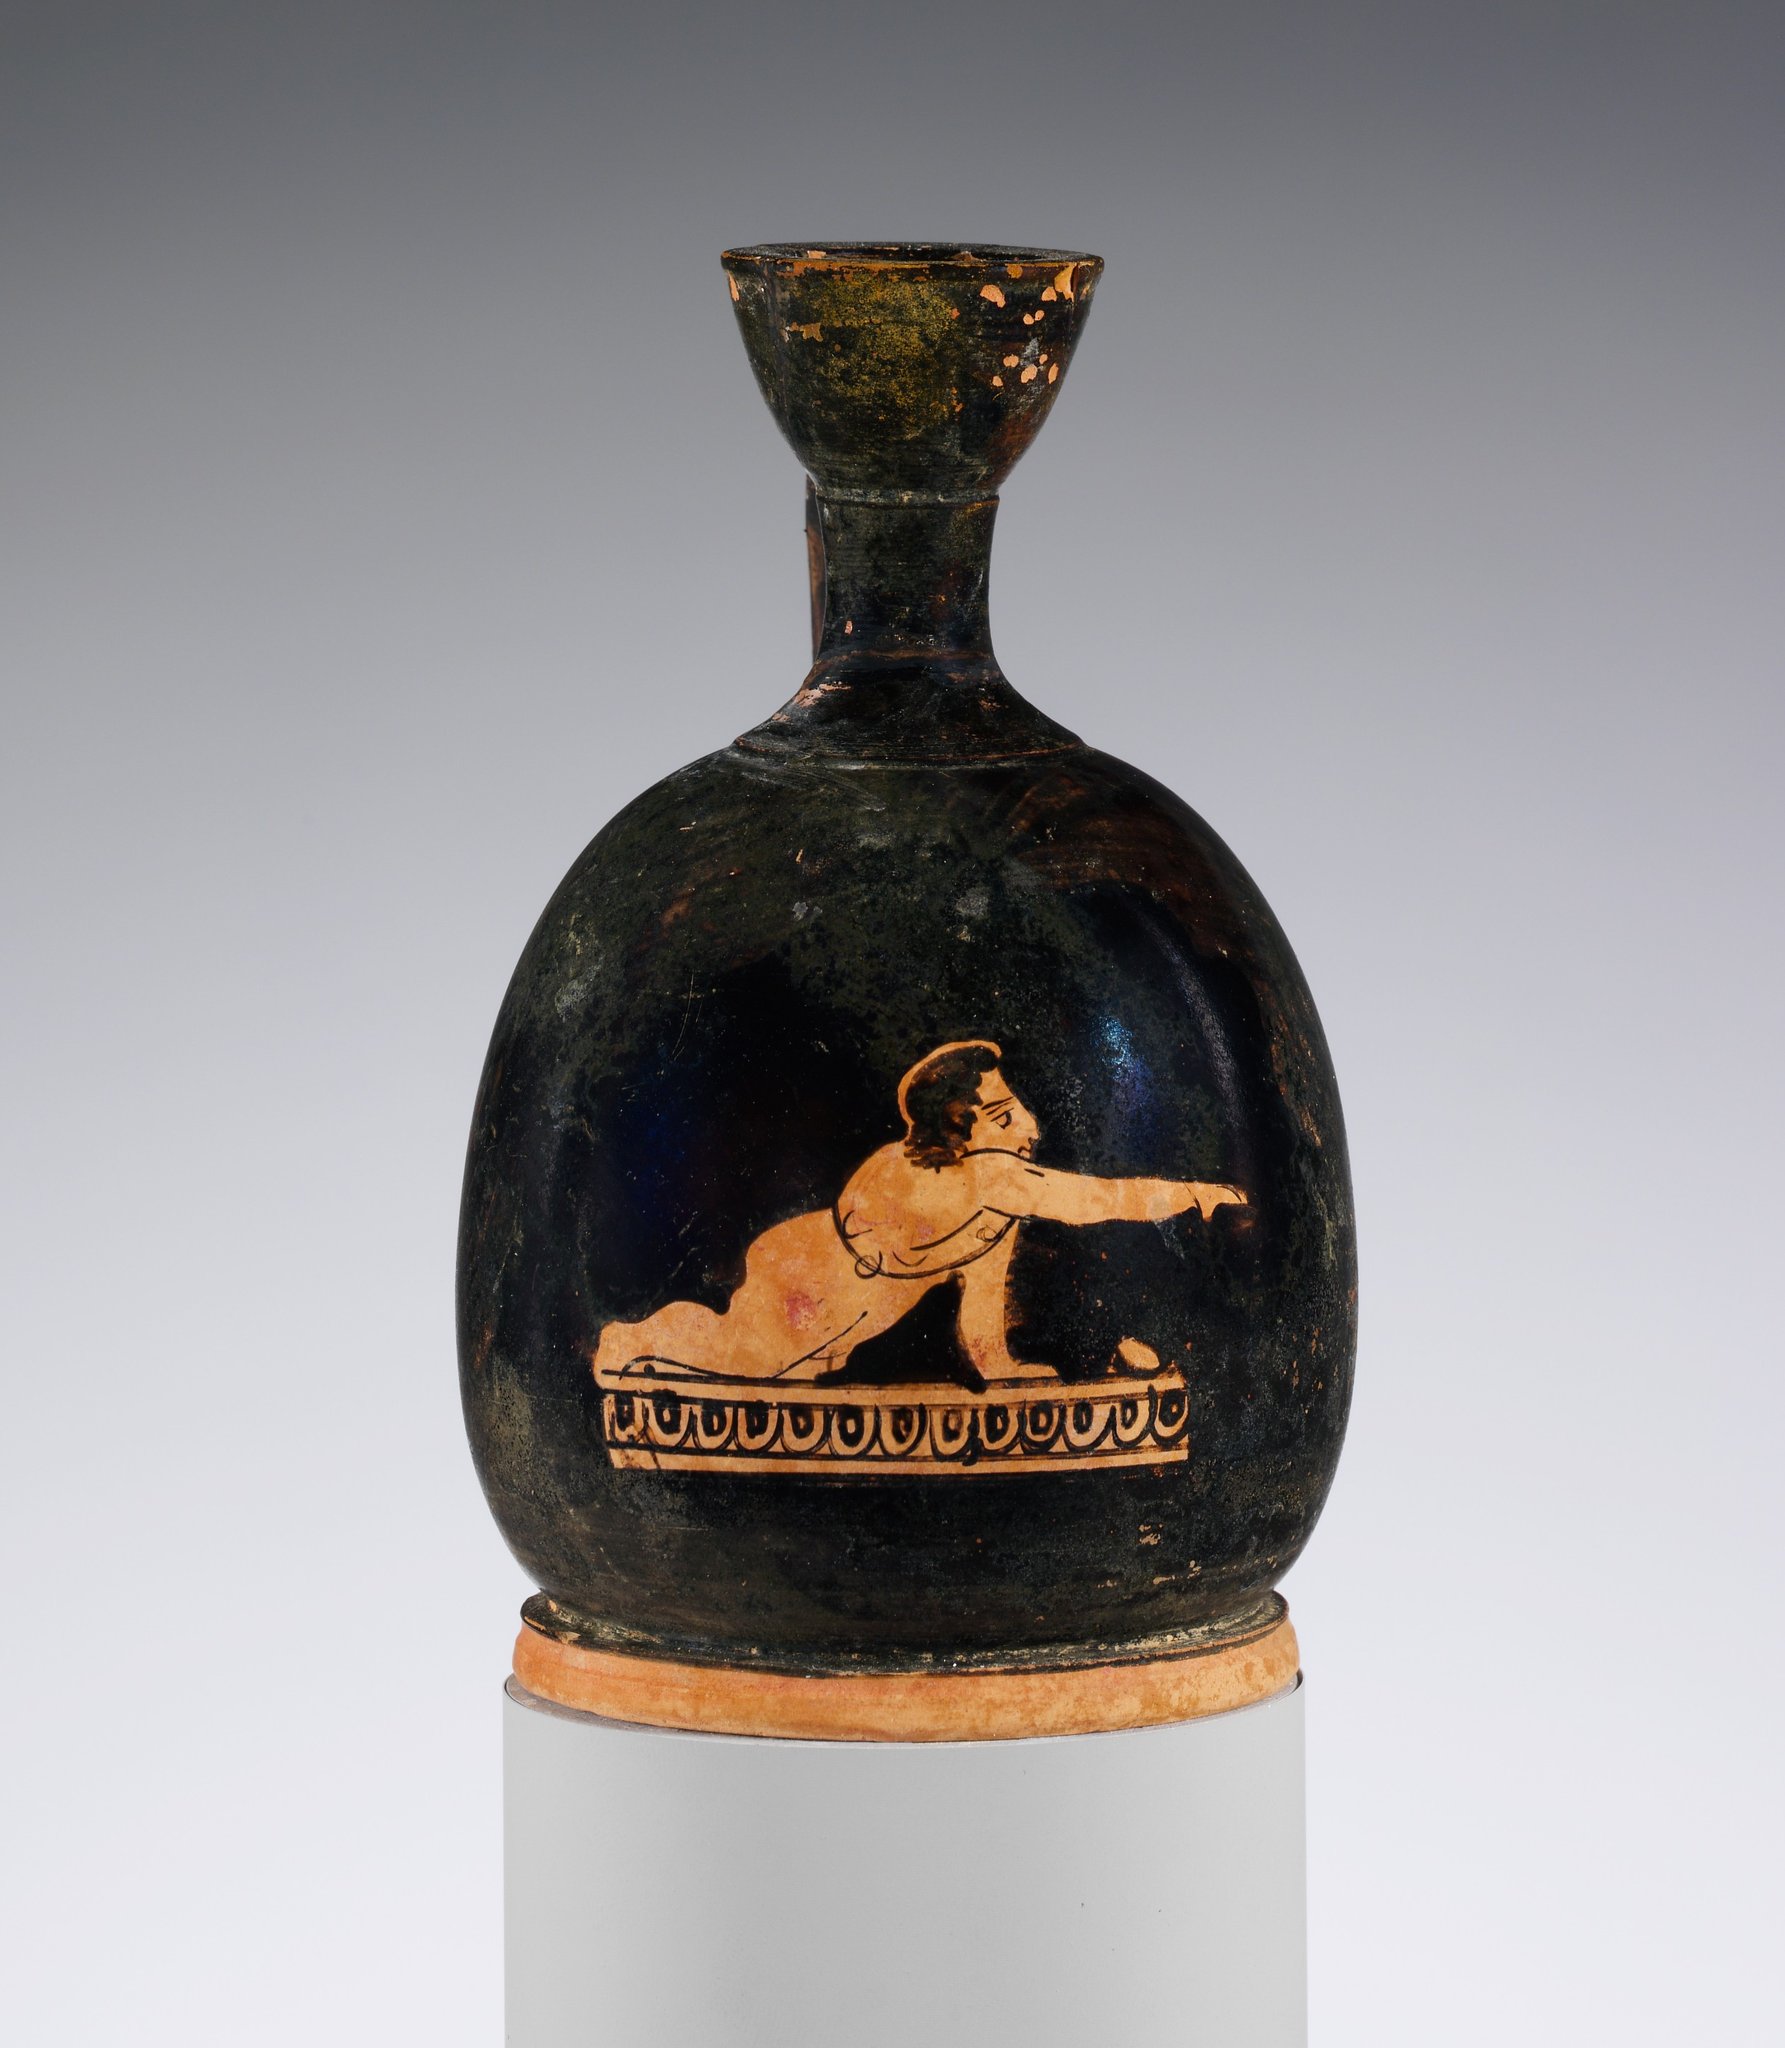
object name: squat lekythos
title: Terracotta squat lekythos (oil flask)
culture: greek, attic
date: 434-401 BCE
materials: terracotta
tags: boys